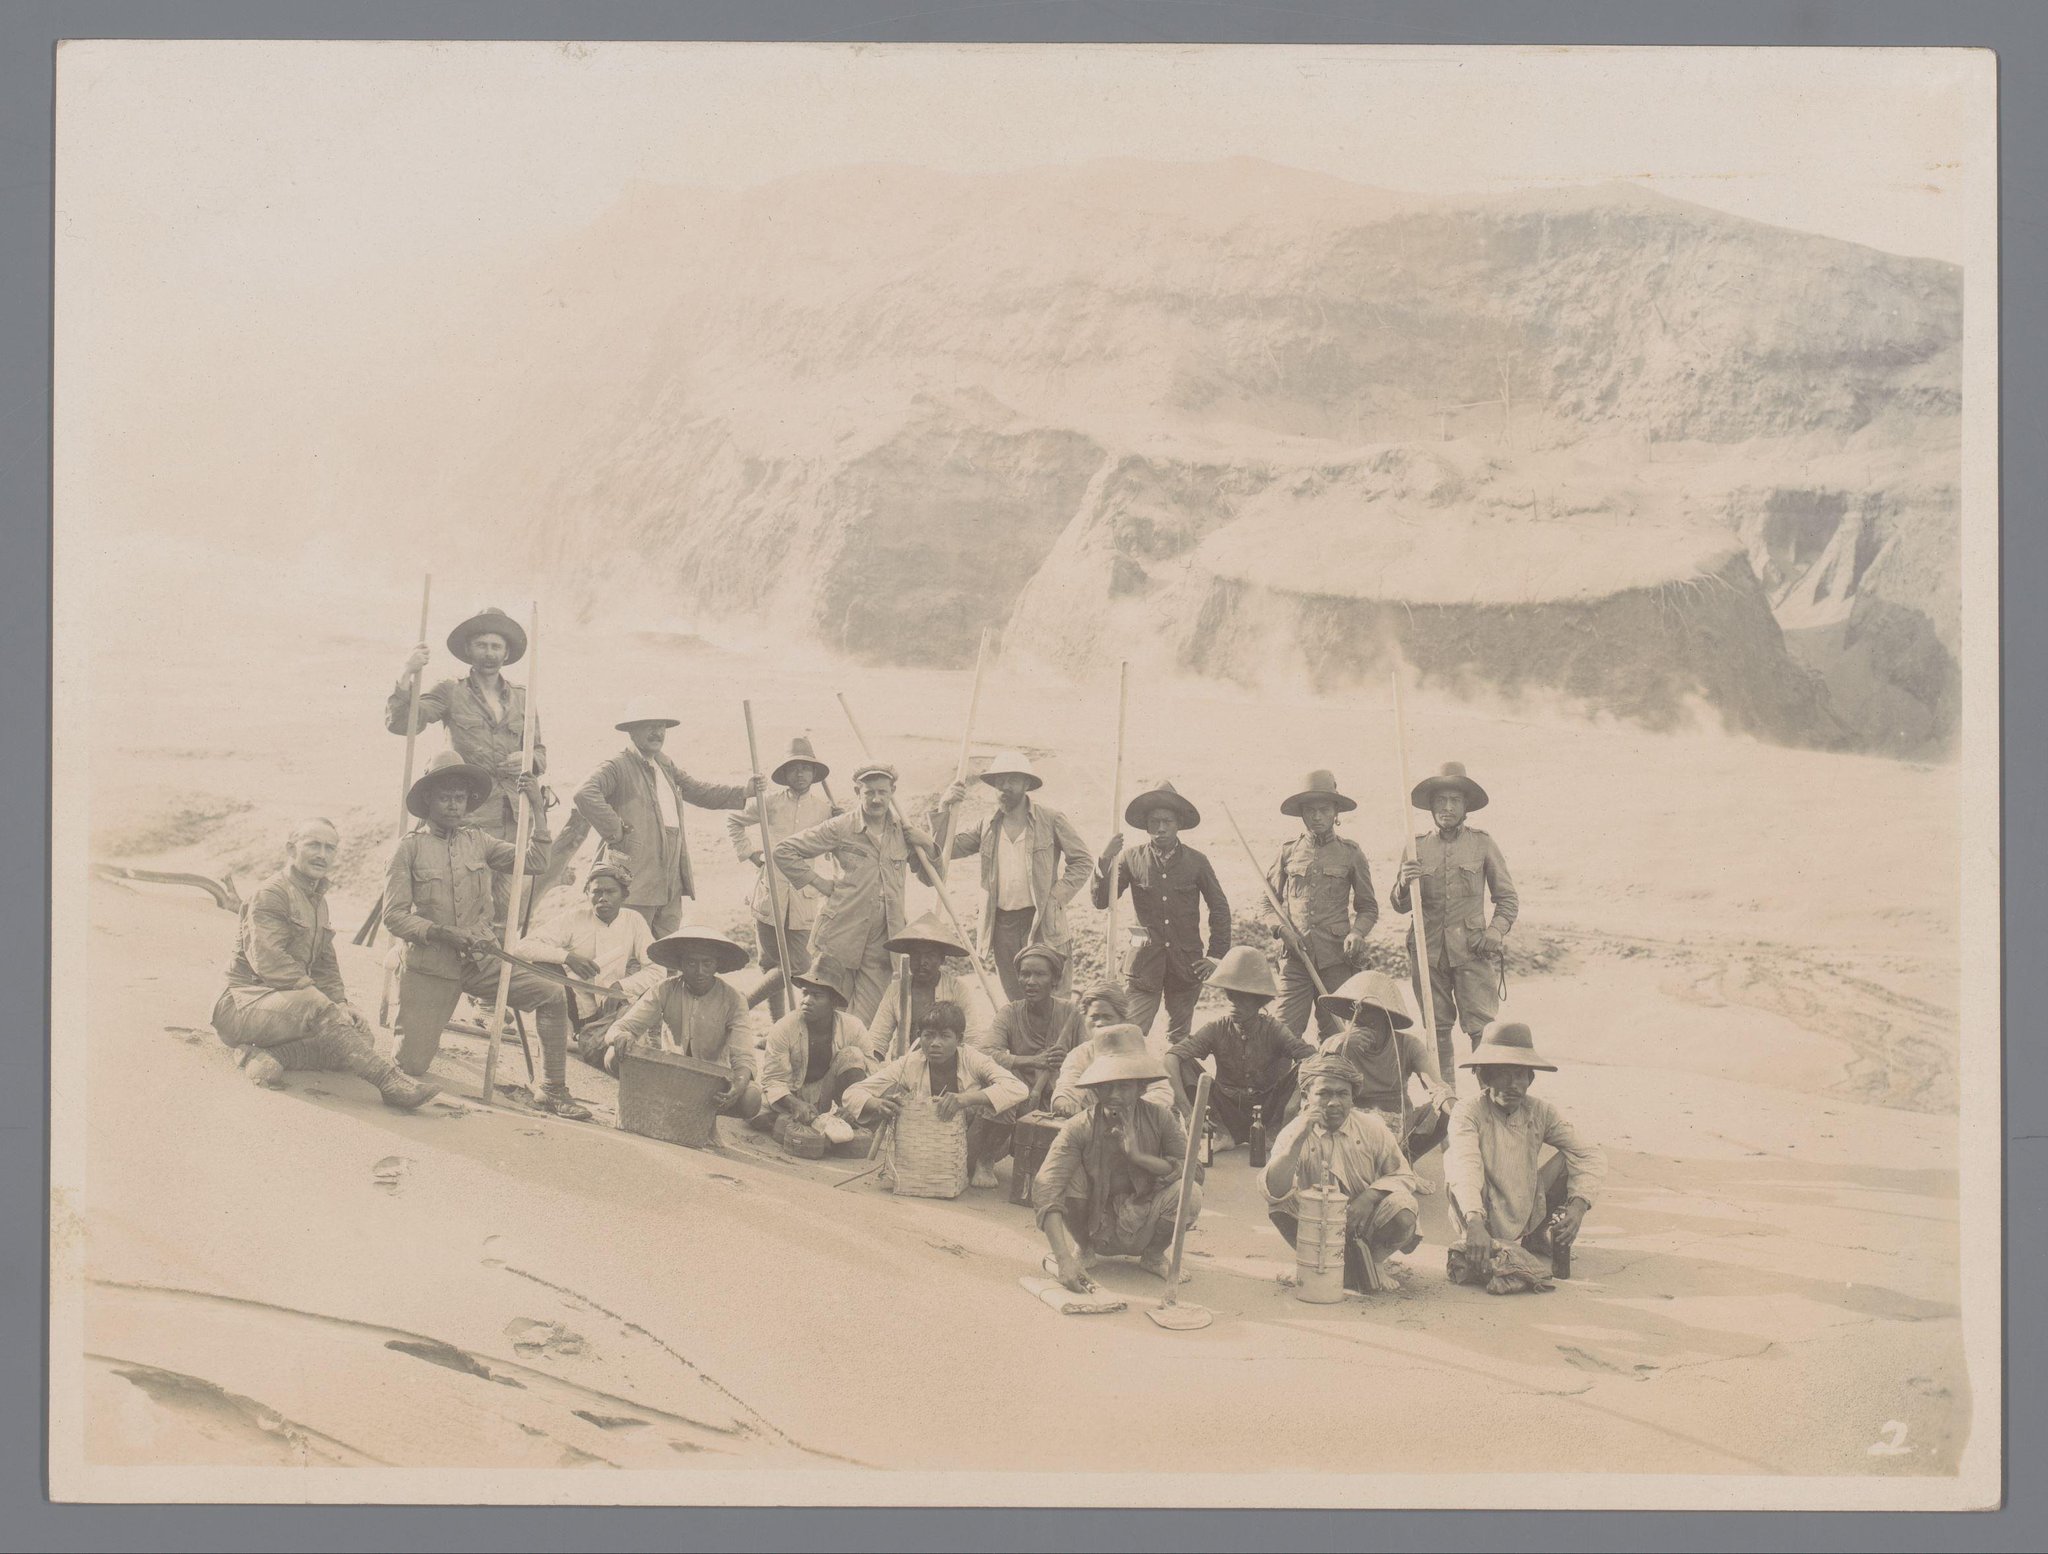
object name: photograph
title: Groepsportret van expeditie [?] voor een berg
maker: onnes kurkdjian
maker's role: fotograaf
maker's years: 1851-1903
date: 1900-1920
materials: cardboard, paper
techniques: albumen print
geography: surabaya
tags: oost-java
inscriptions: inscription: ‘[...weggevallen door scheuring papier] uitbarsten. J. in den midden leider Dr Hemmeling links en rechts. Dr. Coert. Dr. Woert links op de foto de fotograaf der firma Kurkdjian: J.G. Ivken [?]’, number: ‘2.’, inscription: ‘SERIE JAVA//ORIGINEELE OPNAME DOOR//N.V. PHOTOGRAFISCH ATELIER//KURKDJIAN//SOERABAIA JAVA.//This Photograph is copyright & fully protected.//Rechtens verboden te reproduceeren in elken vorm.//Het Auteursrecht op deze photo is verleend volgens Ind. Staatsblad No. 600 Wet 23/9/12//Tous droits reservé. Alle Rechte vorbehalten.’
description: Groepsportret voor een berg. Twintig Oost-Javaanse en Europese mannen van een expeditite (?) met schoppen en zwaarden in de hand poseren voor een berg.